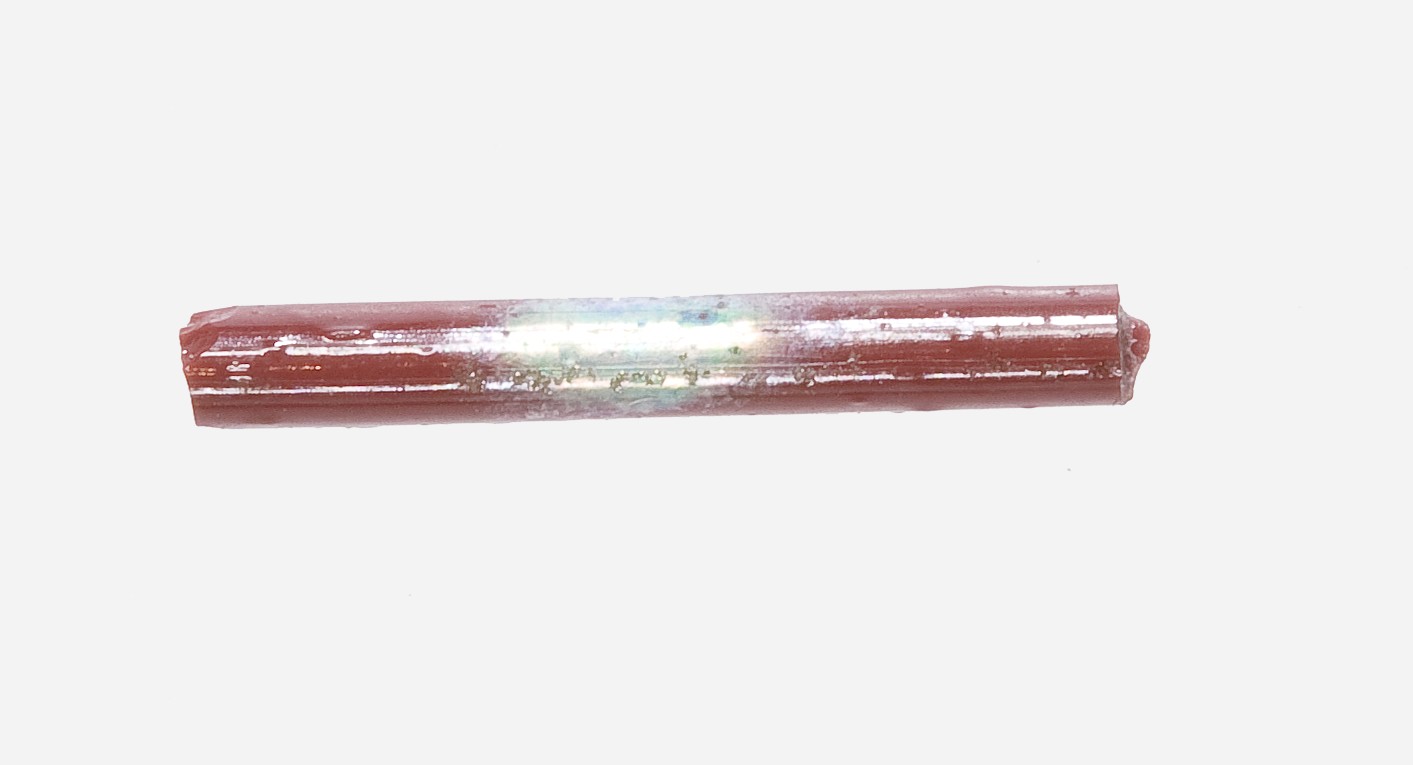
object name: glass rod, black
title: Glass Rod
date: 1390-1352 BCE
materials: glass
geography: egypt